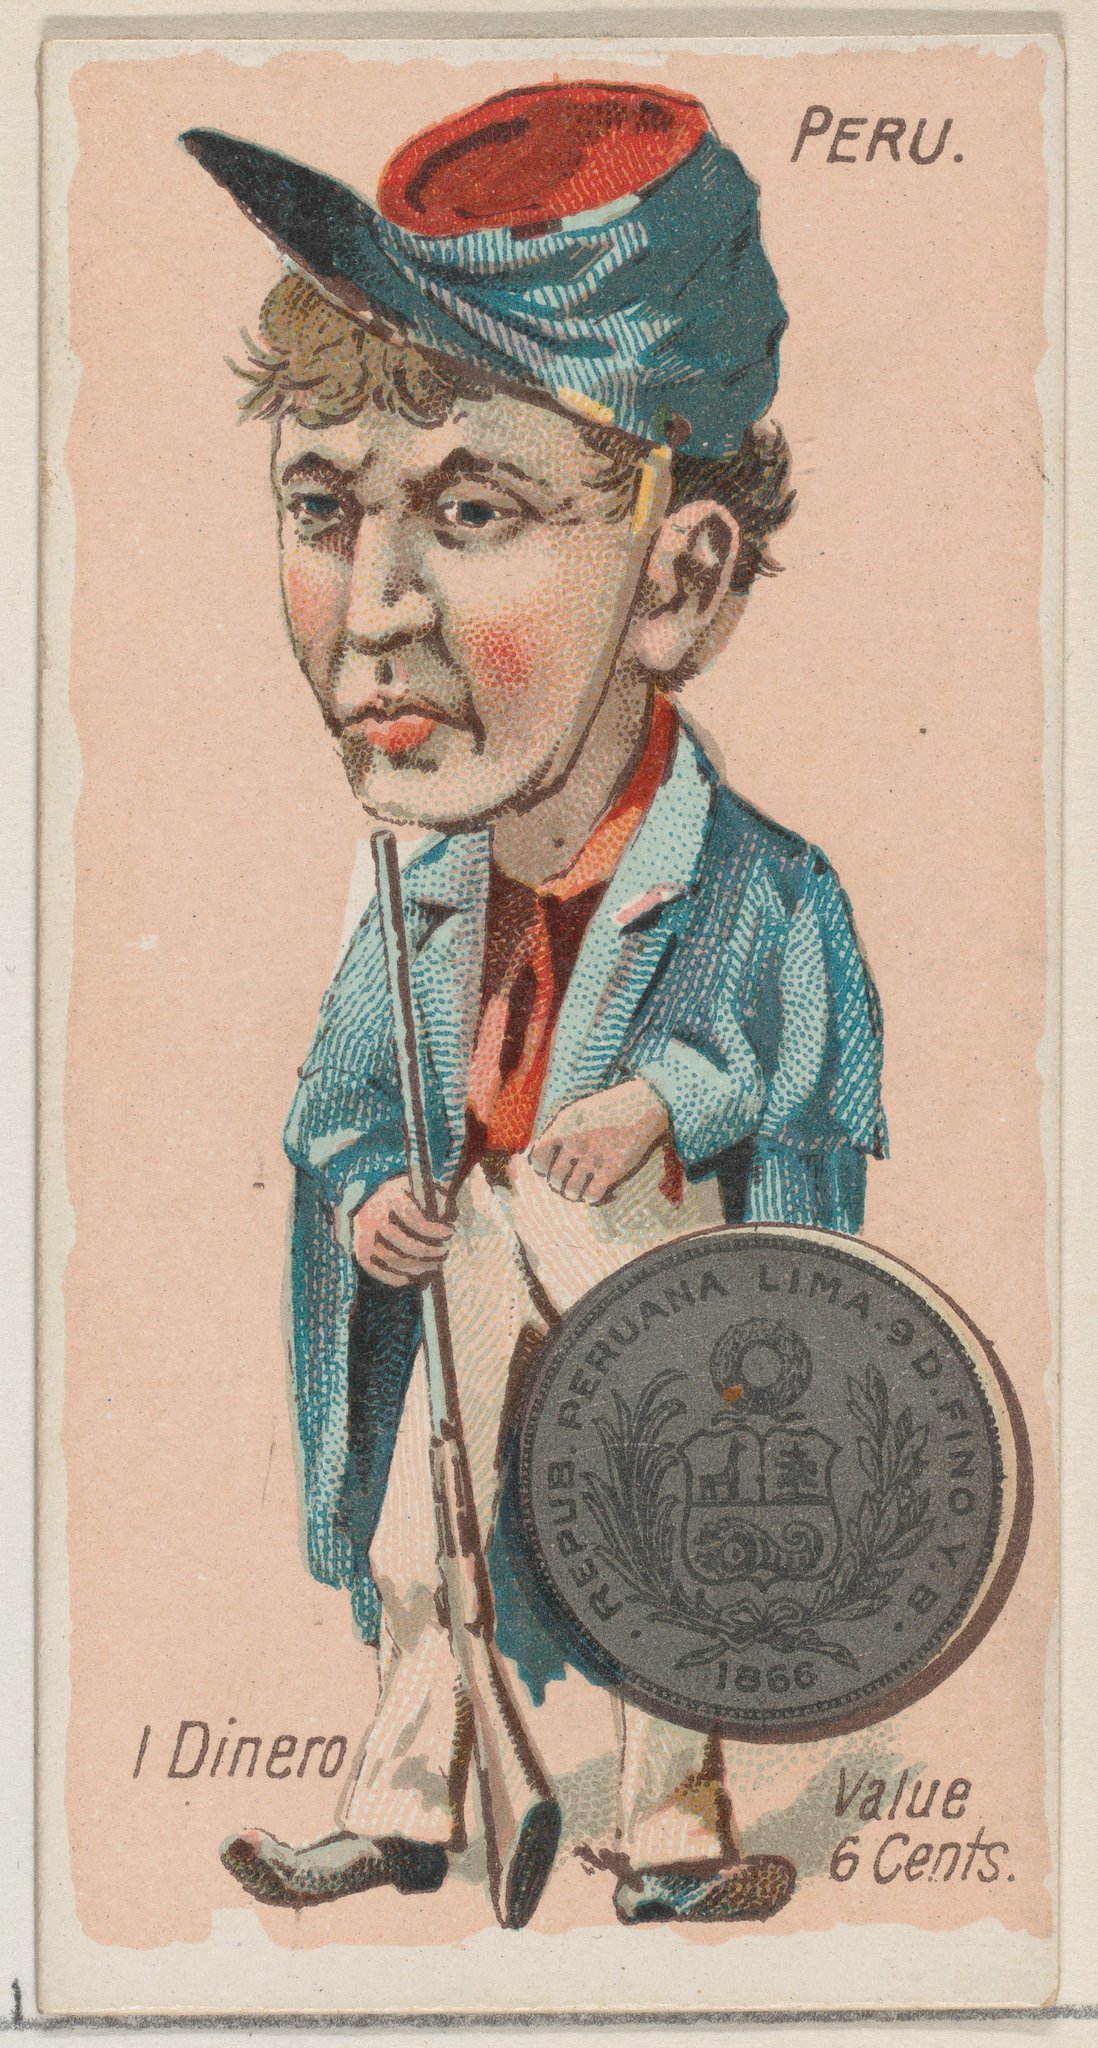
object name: print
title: Peru, 1 Dinero, from the series Coins of All Nations (N72, variation 2) for Duke brand cigarettes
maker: w. duke, sons & co.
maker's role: publisher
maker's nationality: american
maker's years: 1870-1920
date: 1889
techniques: color lithograph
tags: men,coins